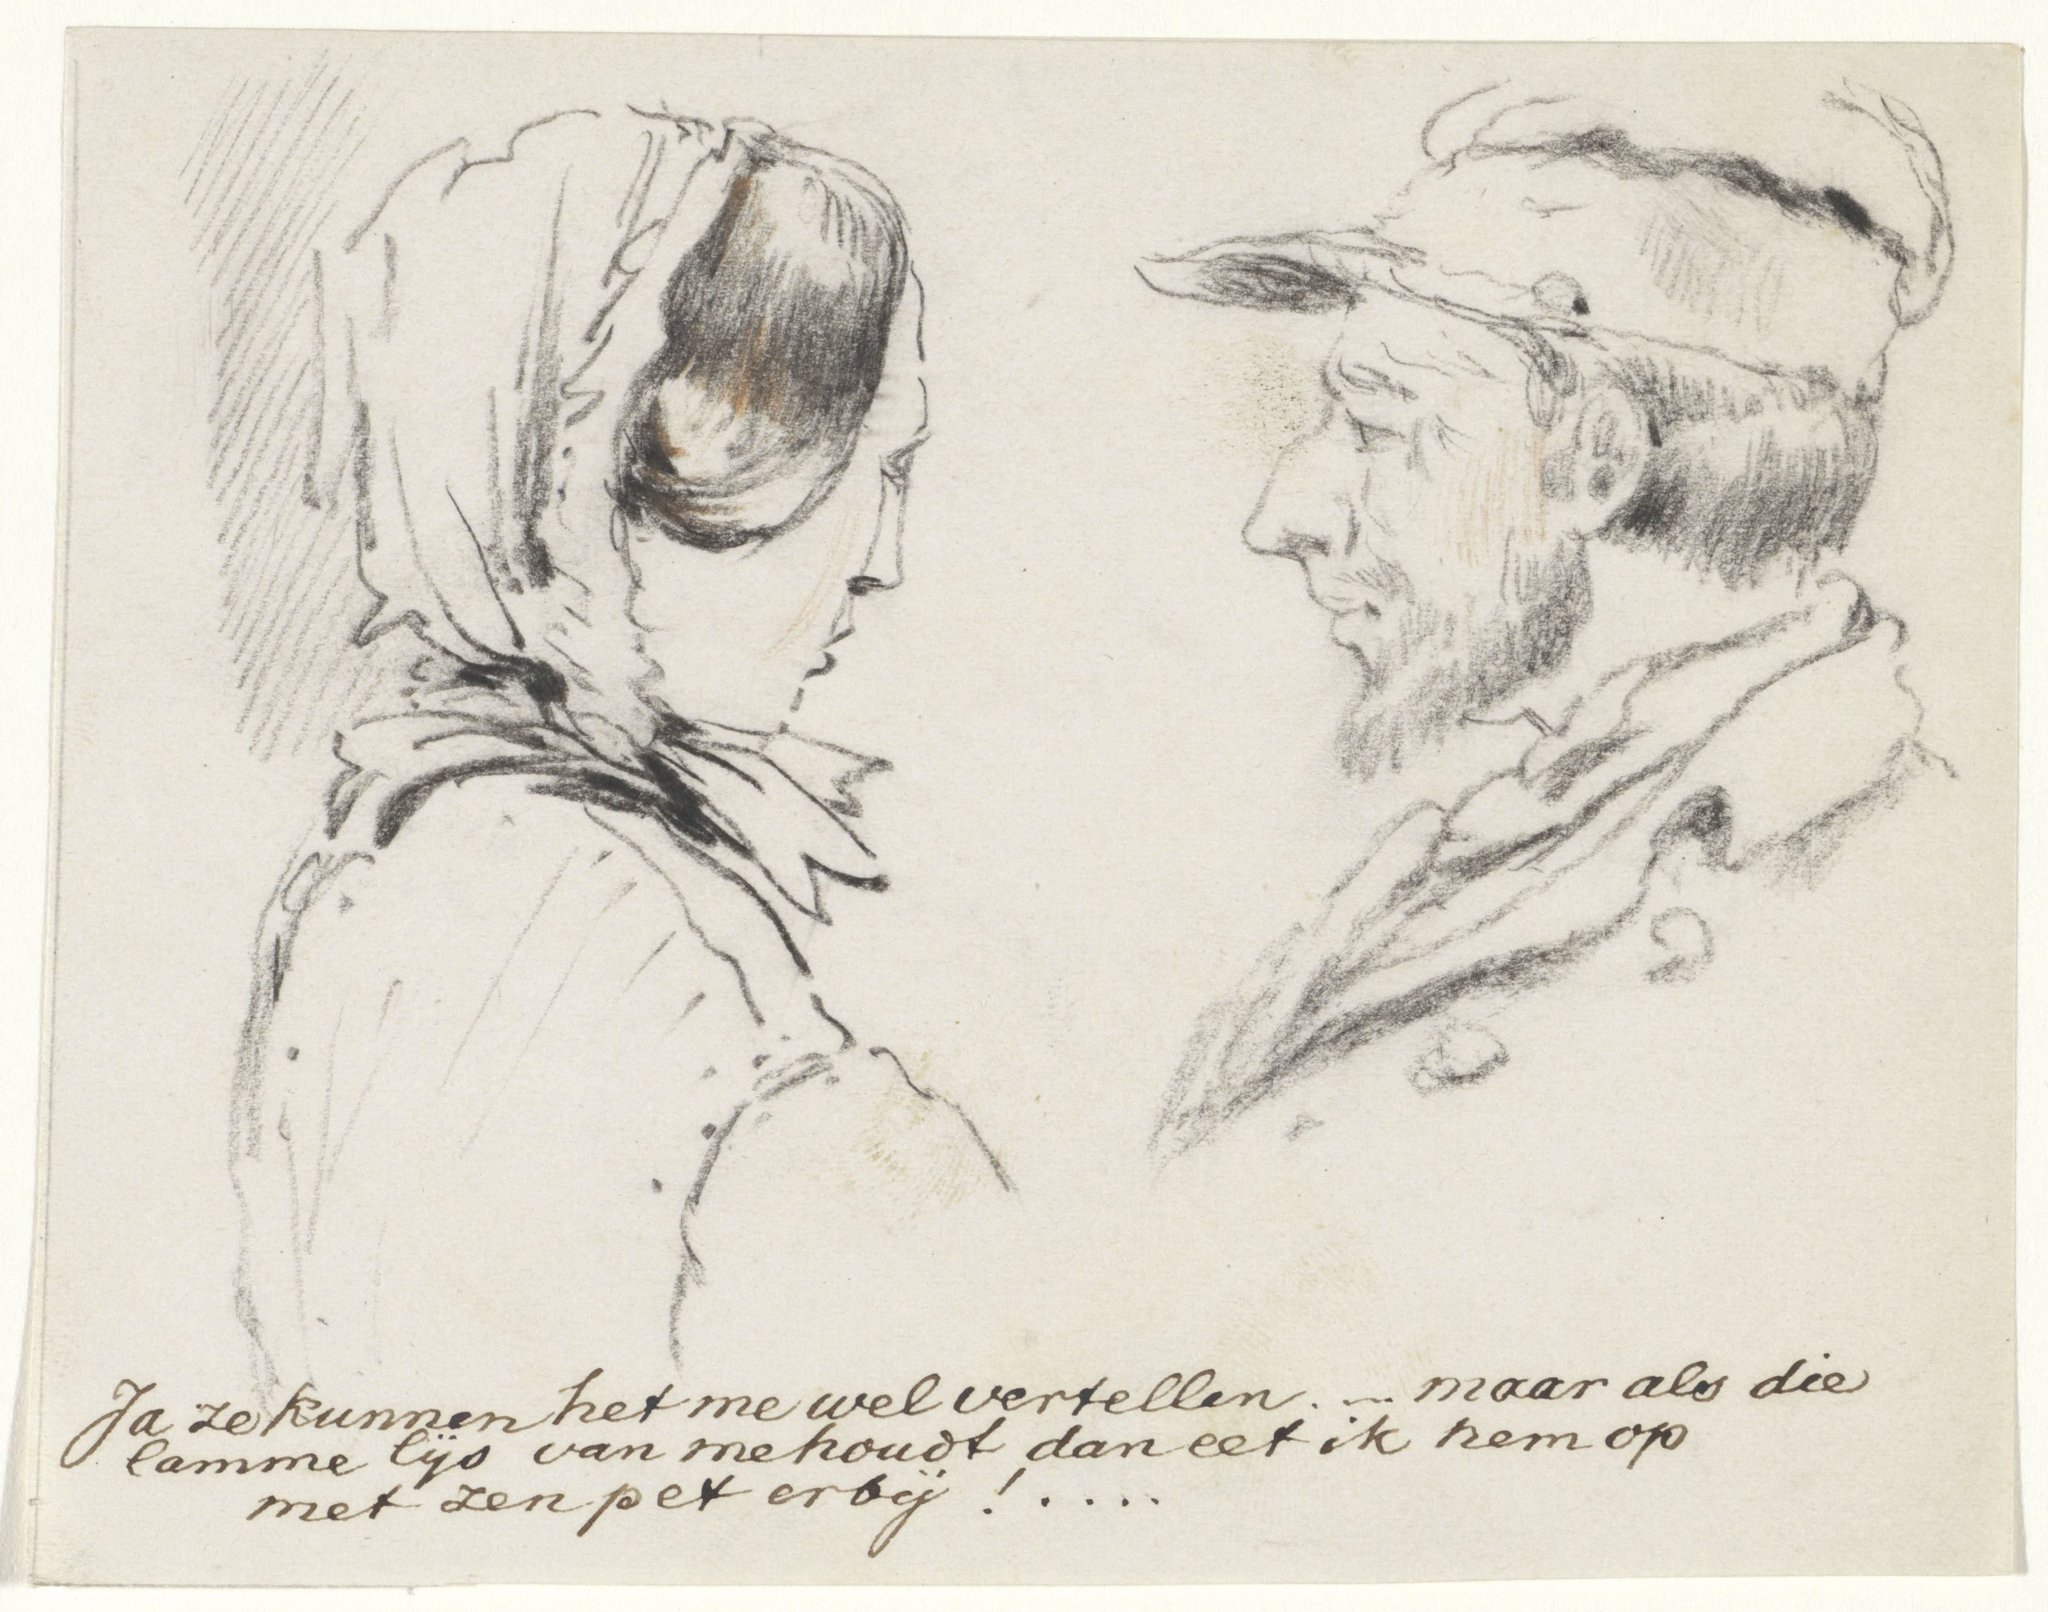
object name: drawing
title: Man en vrouw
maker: pieter van loon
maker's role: draughtsman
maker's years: 1801-1873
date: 1811-1873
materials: chalk, paper